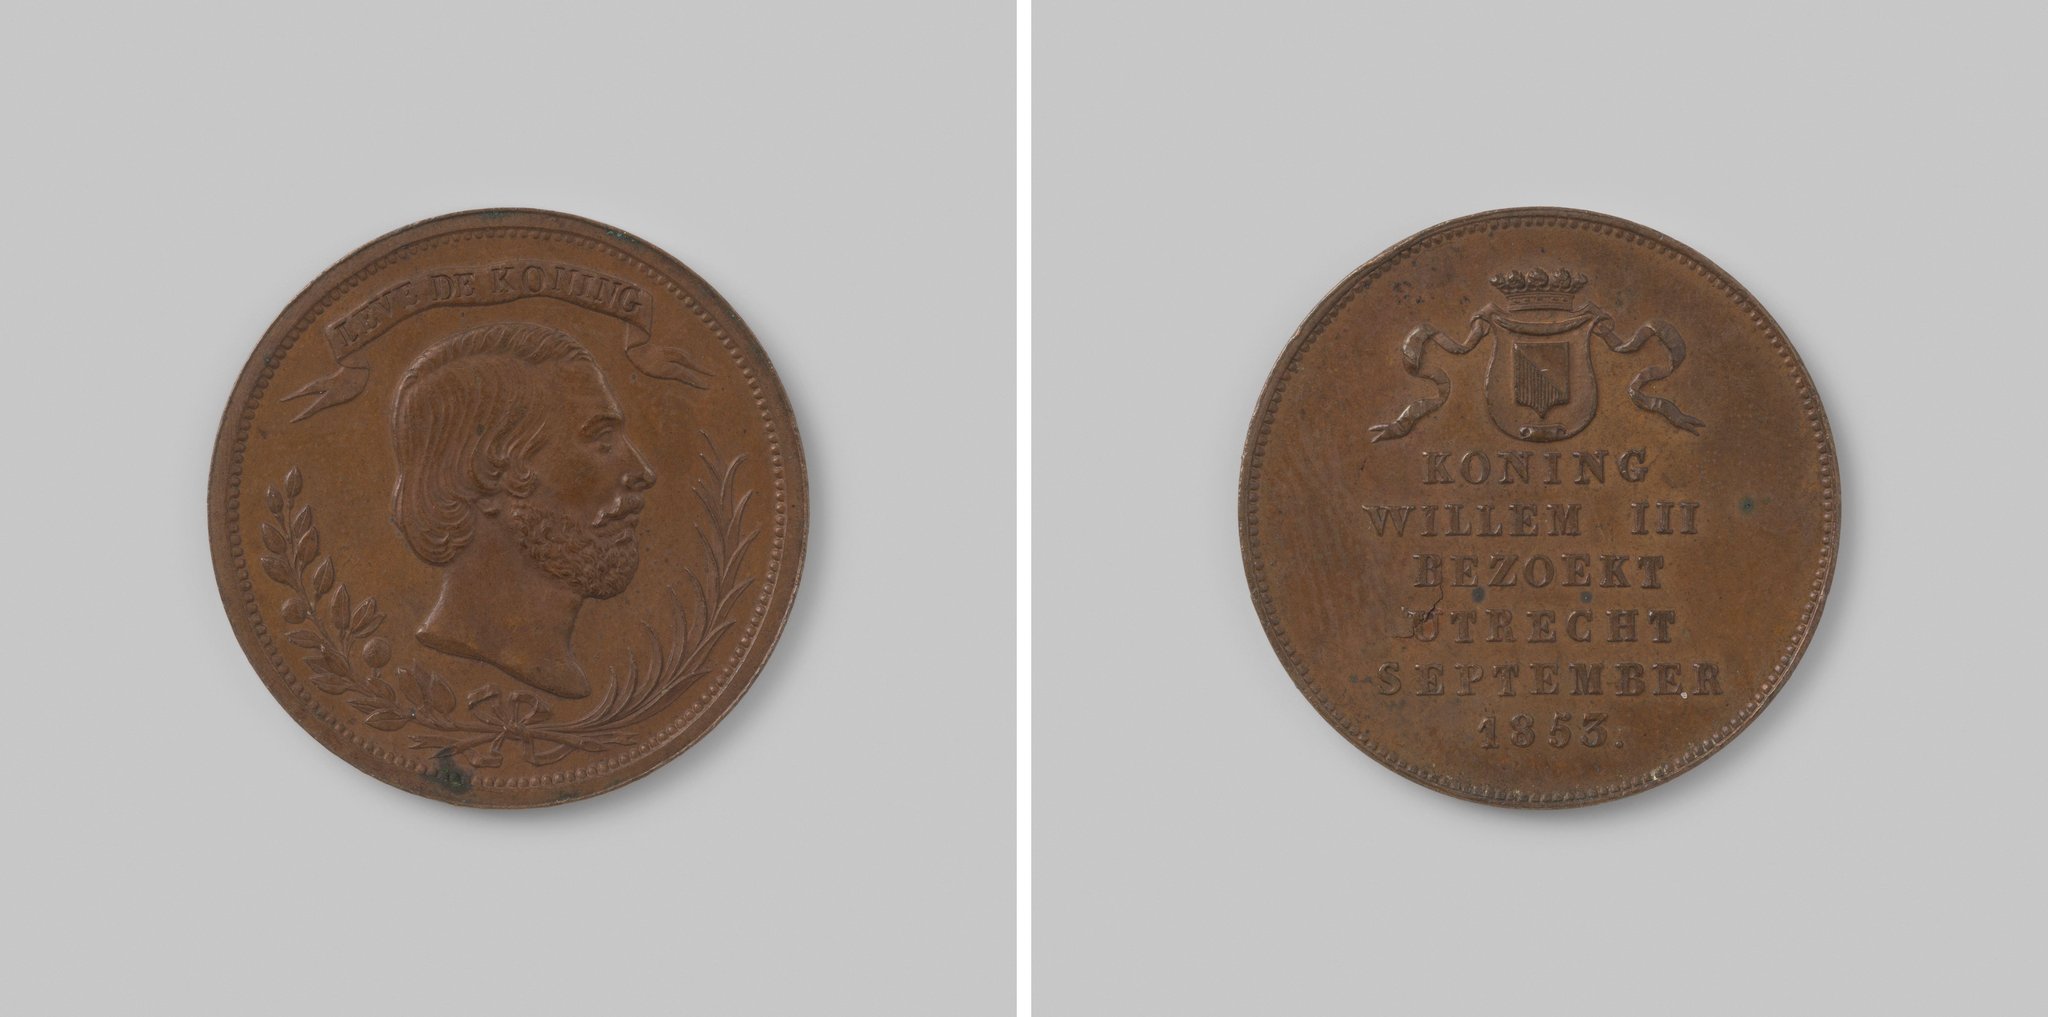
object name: history medal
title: Willem III, koning der Nederlanden bezoekt de stad Utrecht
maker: Anonymous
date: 1853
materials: bronze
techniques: striking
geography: utrecht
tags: brussels, willem iii (koning der nederlanden), utrecht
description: Bronzen penning. Voorzijde: borststuk man onder wimpel met opschrift, boven samengebonden oranje- en palmtak. Keerzijde: opschrift onder gekroond wapenschild met lint